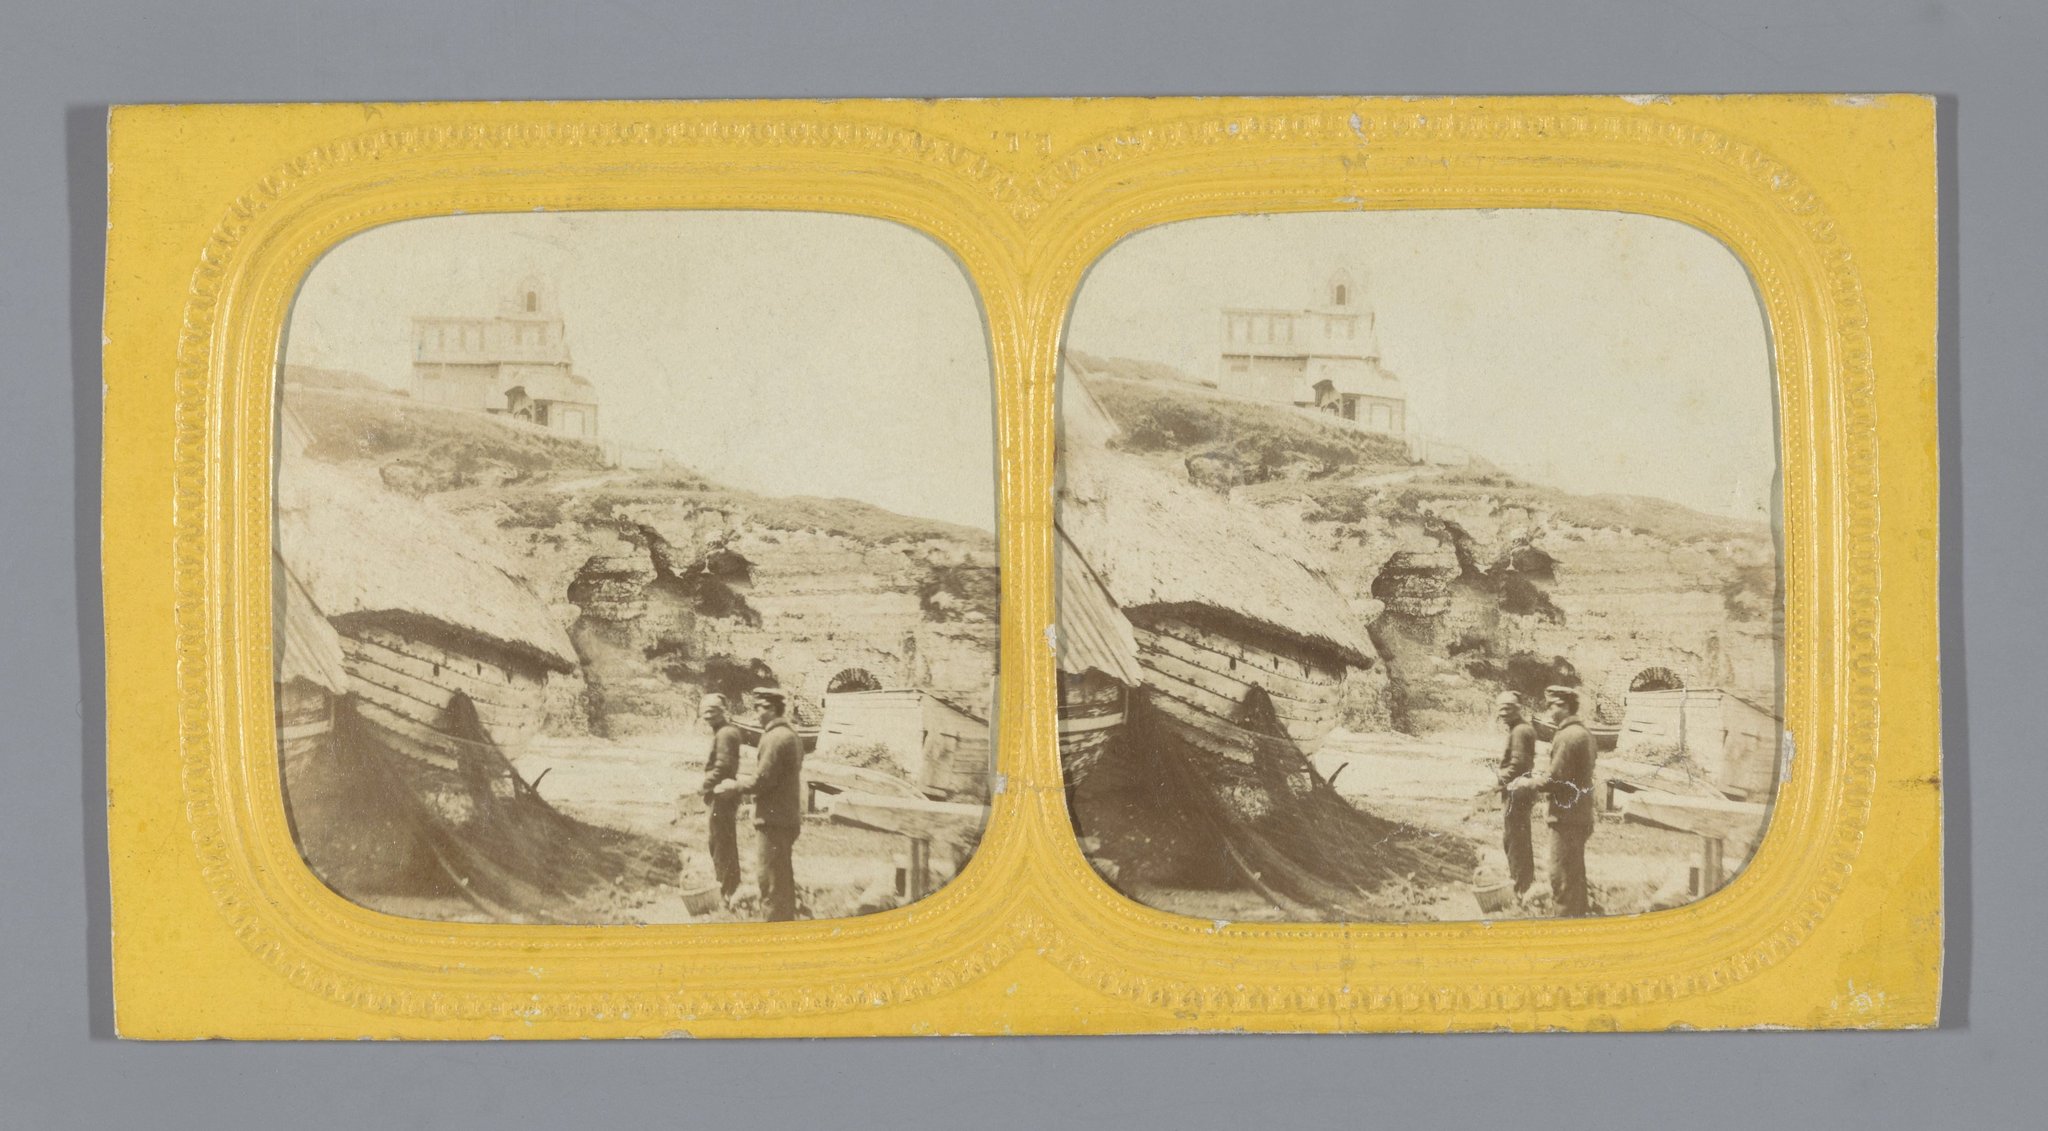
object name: tissue stereograph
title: Strand van Douarnenez, Frankrijk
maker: Anonymous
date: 1855-1875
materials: cardboard, paper, photographic support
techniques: albumen print, hand coloring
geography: douarnenez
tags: rocky coast, church (exterior), beach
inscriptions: monogram: ‘E.L.’